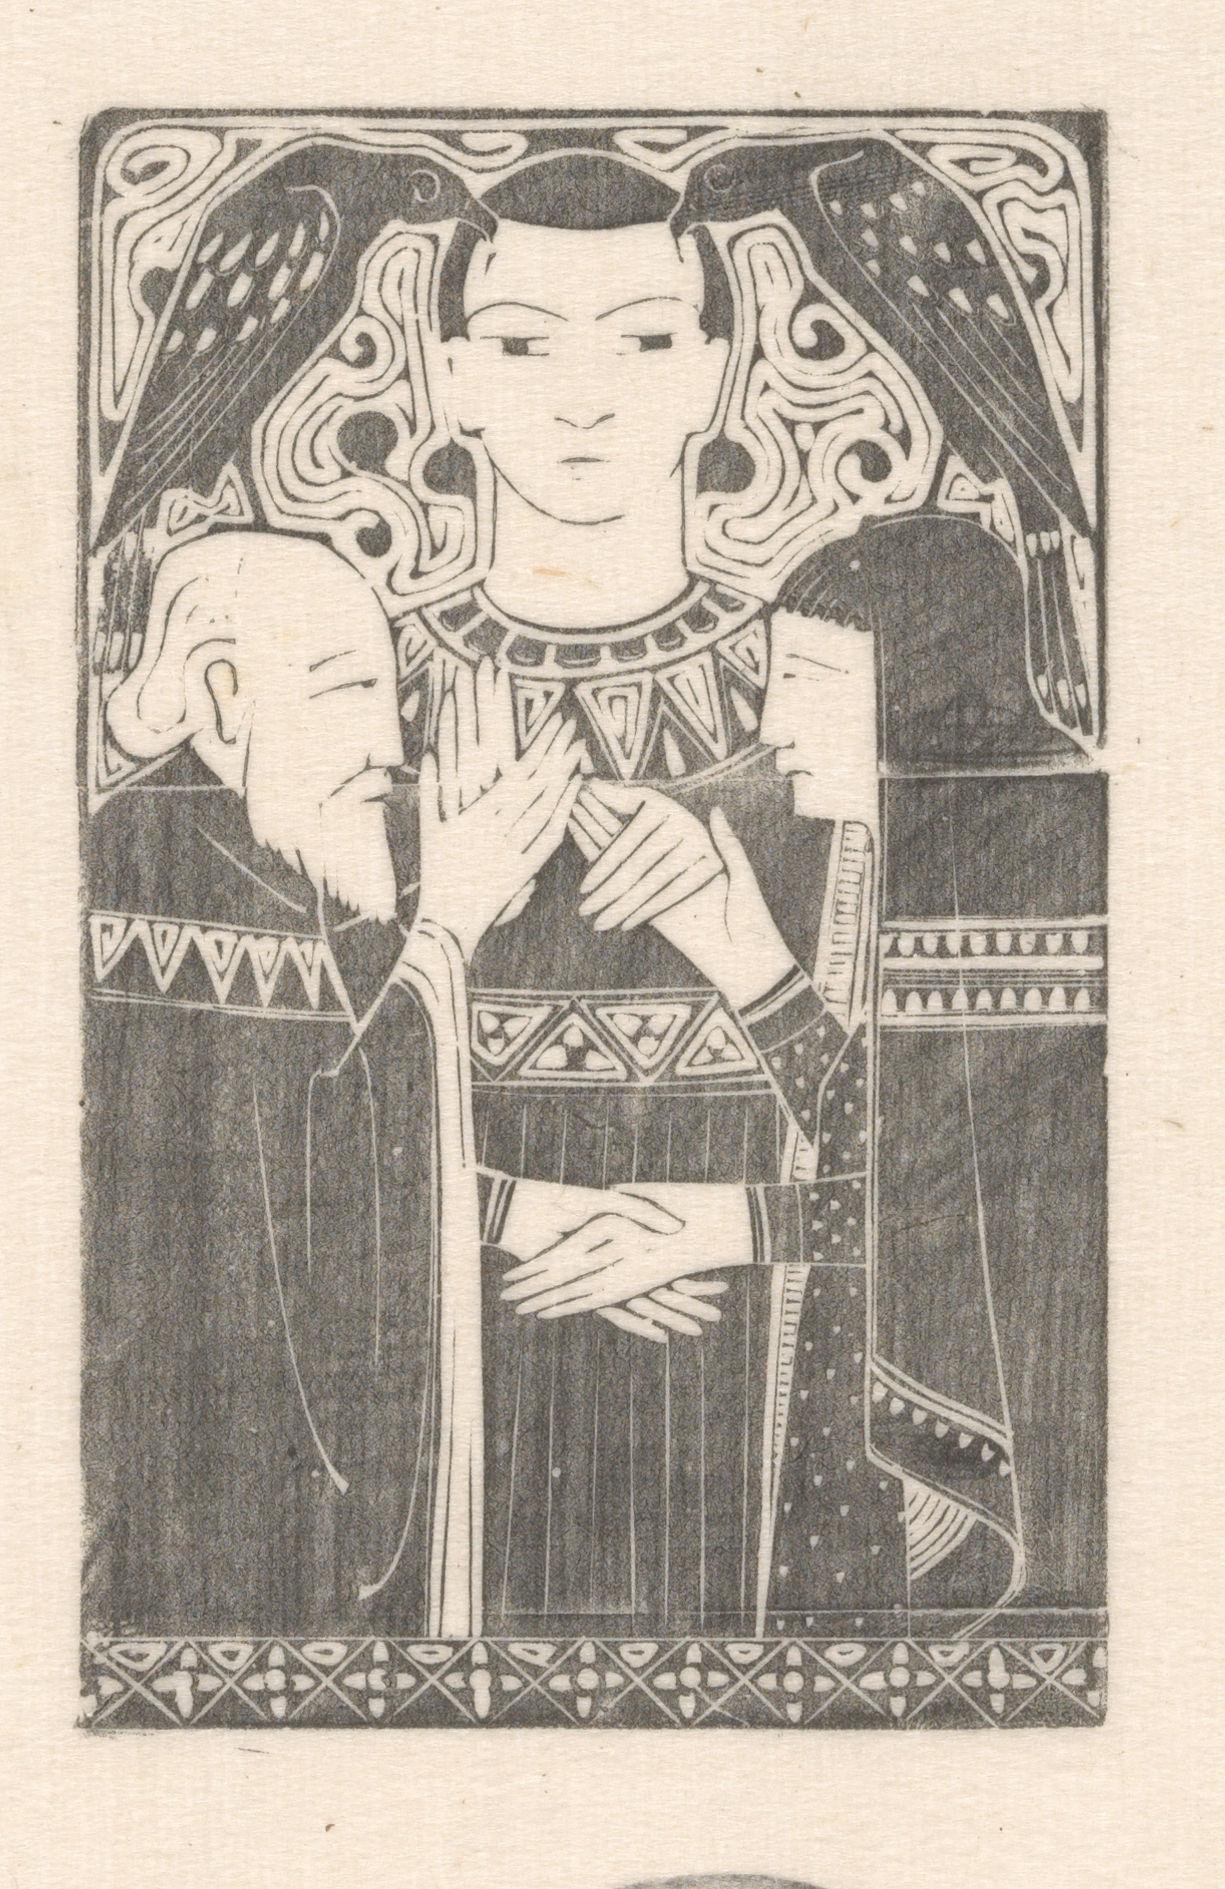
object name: illustration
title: Engel bij een man en vrouw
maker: karel petrus cornelis de bazel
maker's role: draughtsman, print maker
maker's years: 1869-1923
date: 1895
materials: paper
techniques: woodcut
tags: angels, gripping someone by the hand or the wrist; clasped hands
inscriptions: collector's mark: Lugt 2228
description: Een engel houdt de hand vast van een man en een vrouw, die op hun beurt ook elkaars hand vasthouden.